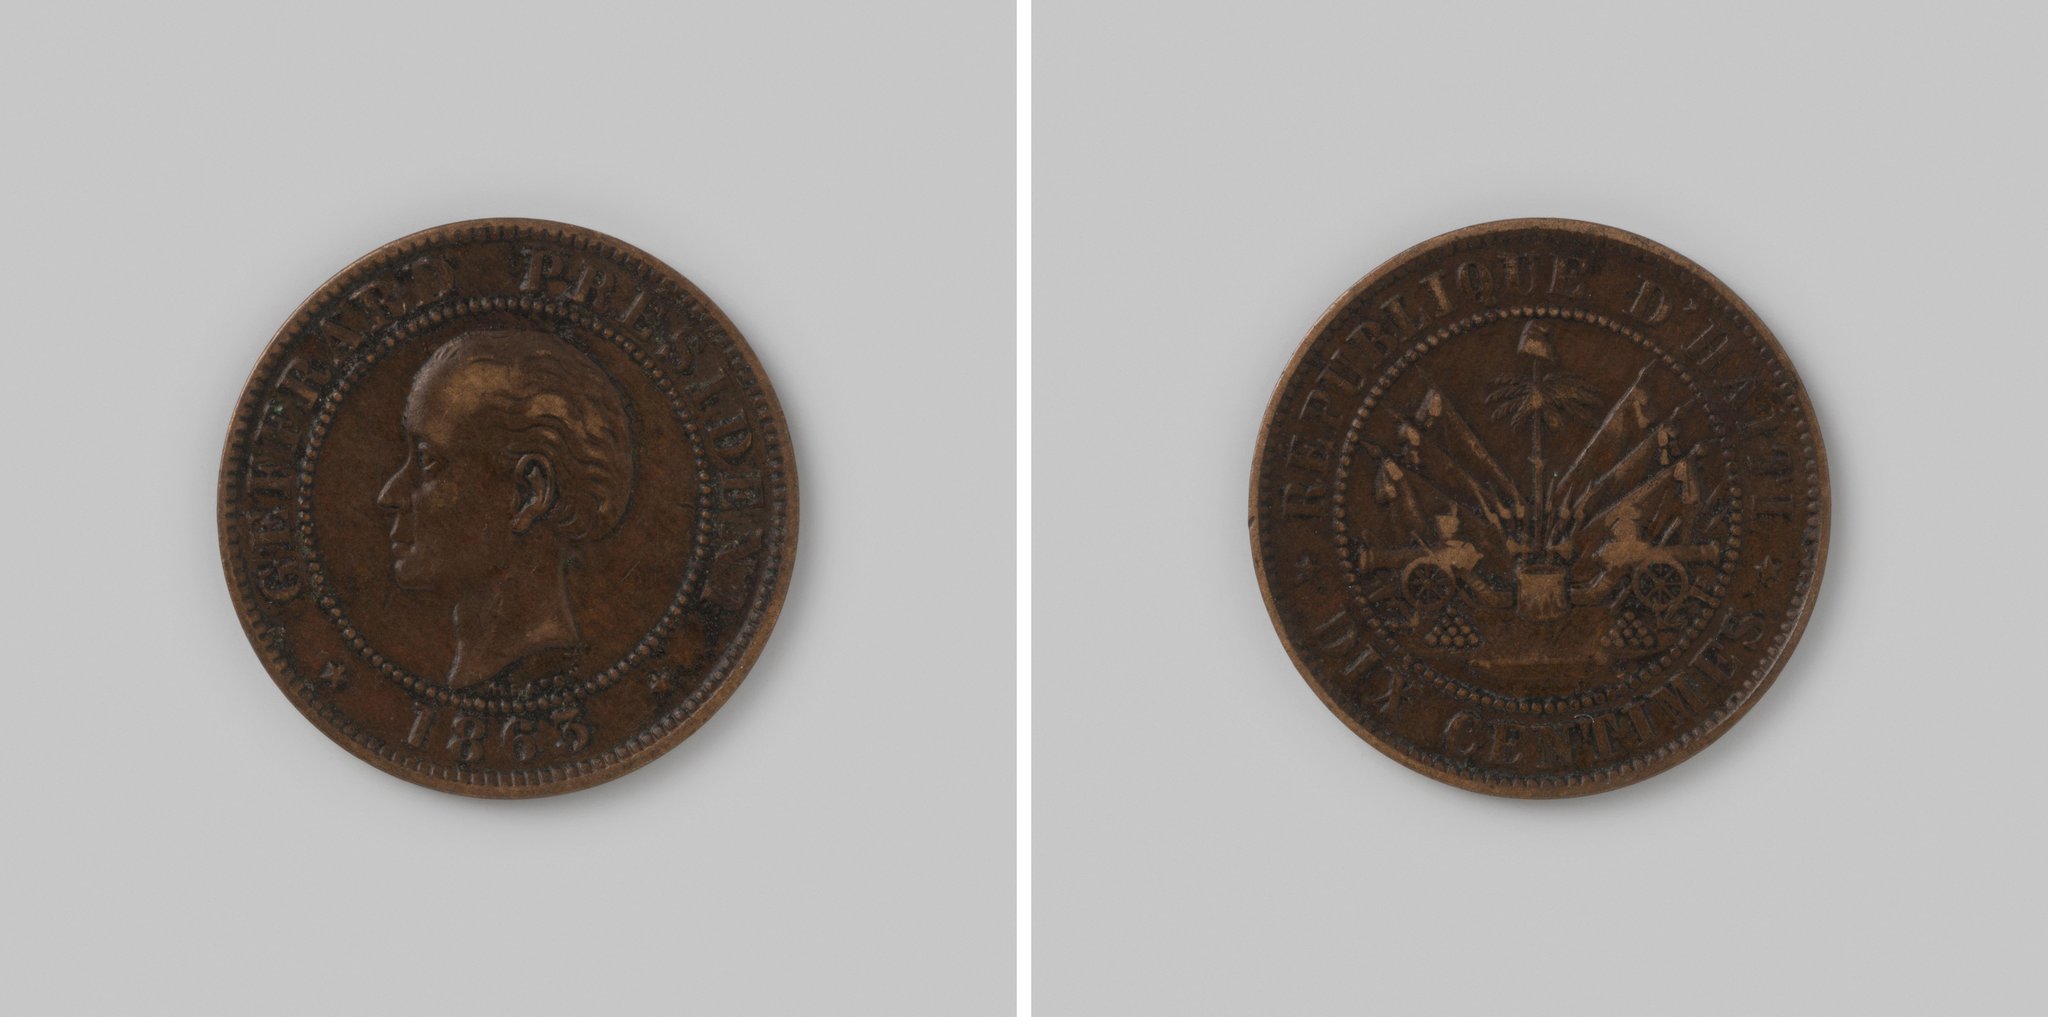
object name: coin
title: Haïti, N.F. Geffard, 10 centimes, 1863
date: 1863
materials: copper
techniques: striking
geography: birmingham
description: Koperen munt. Voorzijde: hoofd van de president naar links. Keerzijde: uit trommel oprijzende palmboom, waarachter banieren. links en rechts van trommel twee kanonnen, waaronder stapel kogels. Onderaan waarde-aanduiding. Gladde rand. Geslagen bij Heaton, Birmingham